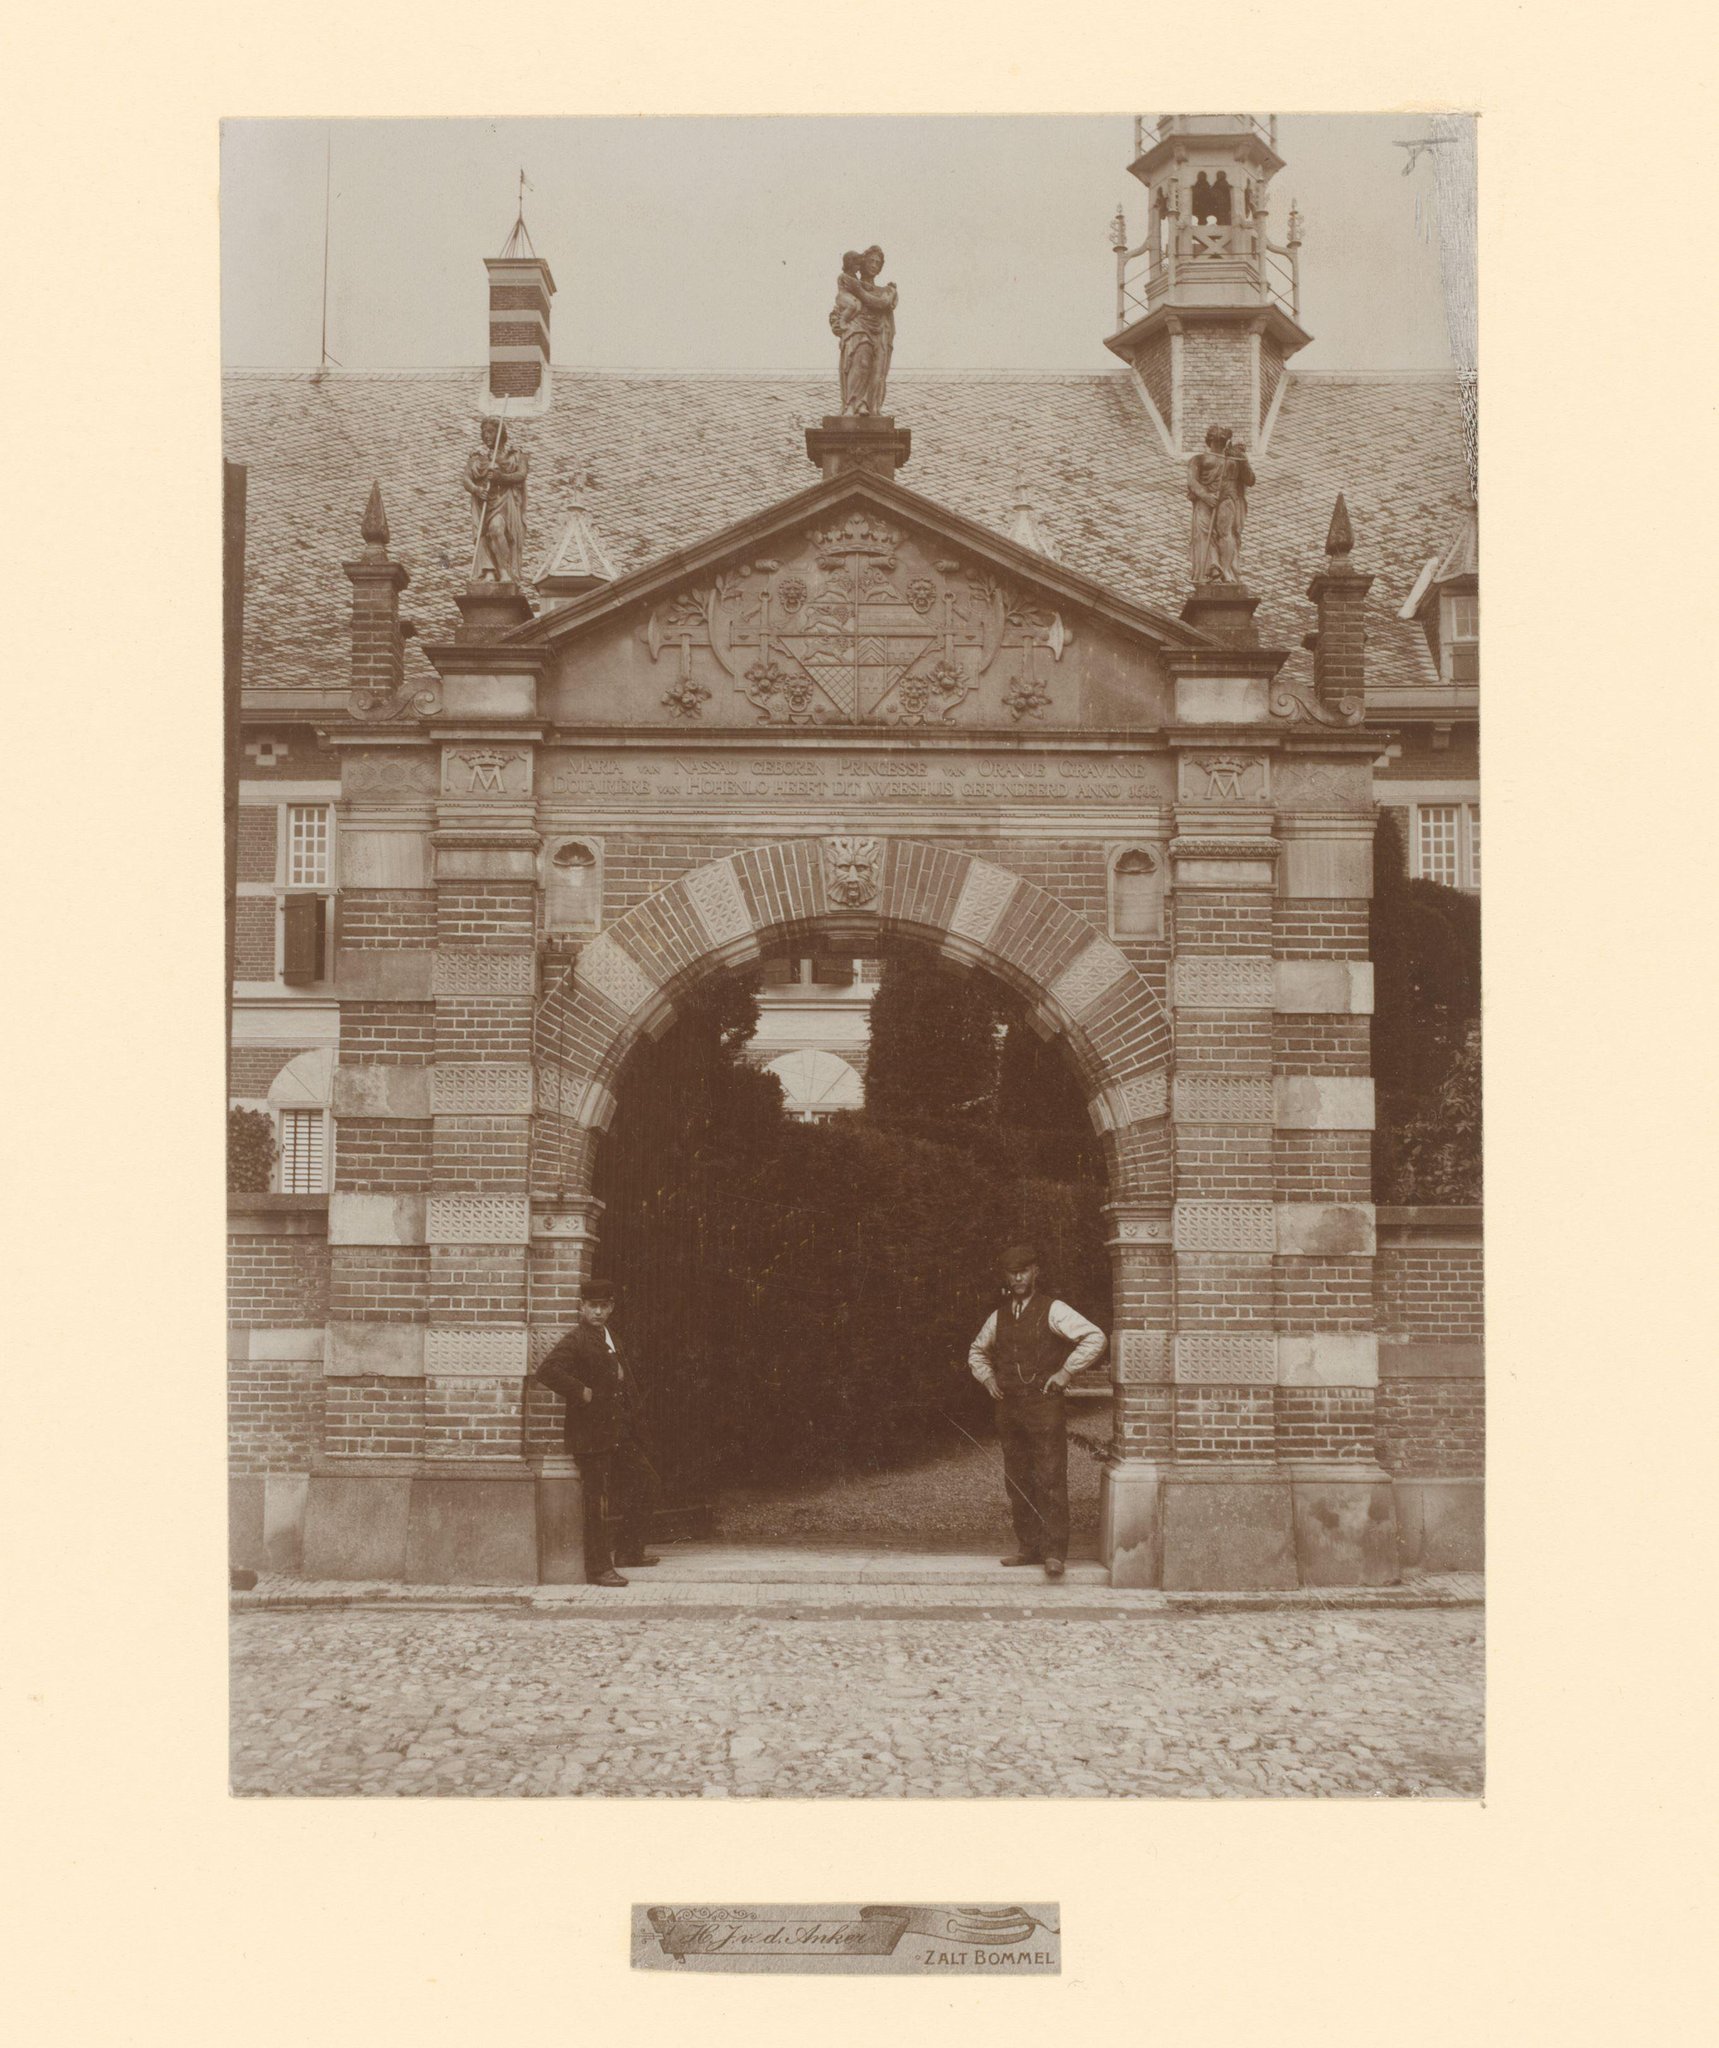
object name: photograph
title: Poort van het Koninklijk Weeshuis te Buren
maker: hendrikus jacobus van den anker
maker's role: fotograaf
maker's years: 1875-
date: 1895-1916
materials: cardboard, photographic support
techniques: collodion silver print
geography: buren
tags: orphanage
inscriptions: inscription: ‘H.J. v.d. Anker/ Zaltbommel’, annotation: ‘Poort of hoofdingang van het Weeshuis te Buren’, annotation: ‘Weeshuis/ Buren’